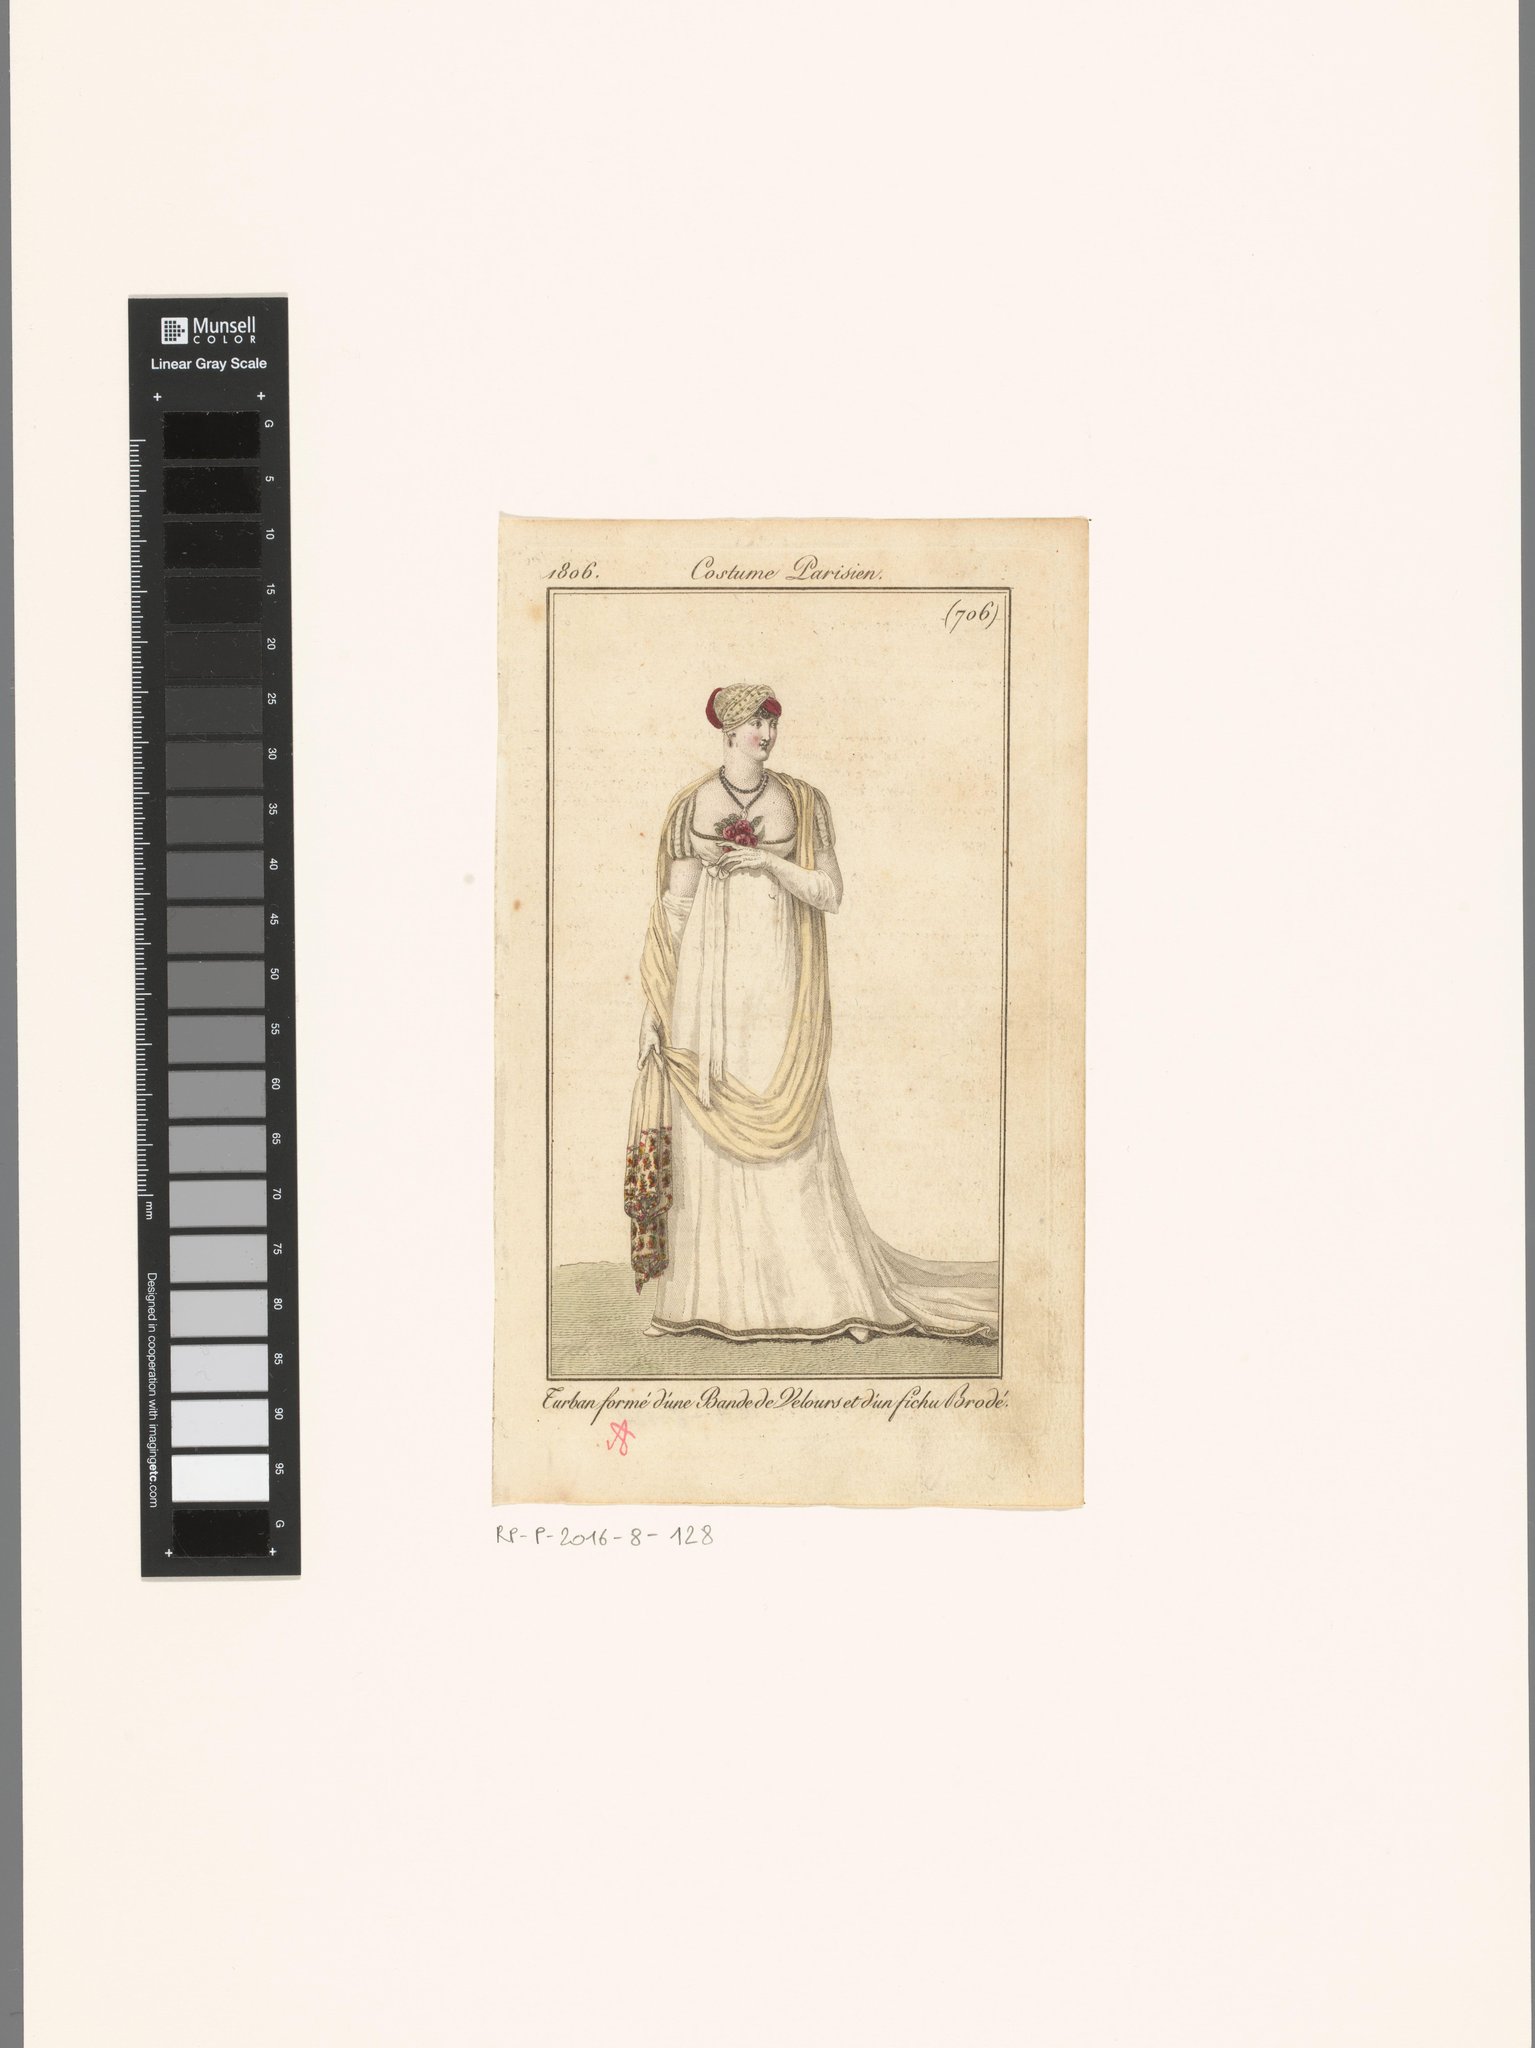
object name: fashion print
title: Journal des Dames et des modes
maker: Anonymous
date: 1806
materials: paper, ink, watercolor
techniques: etching, hand coloring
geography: france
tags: fashion plates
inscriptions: collector's mark: Lugt 2228